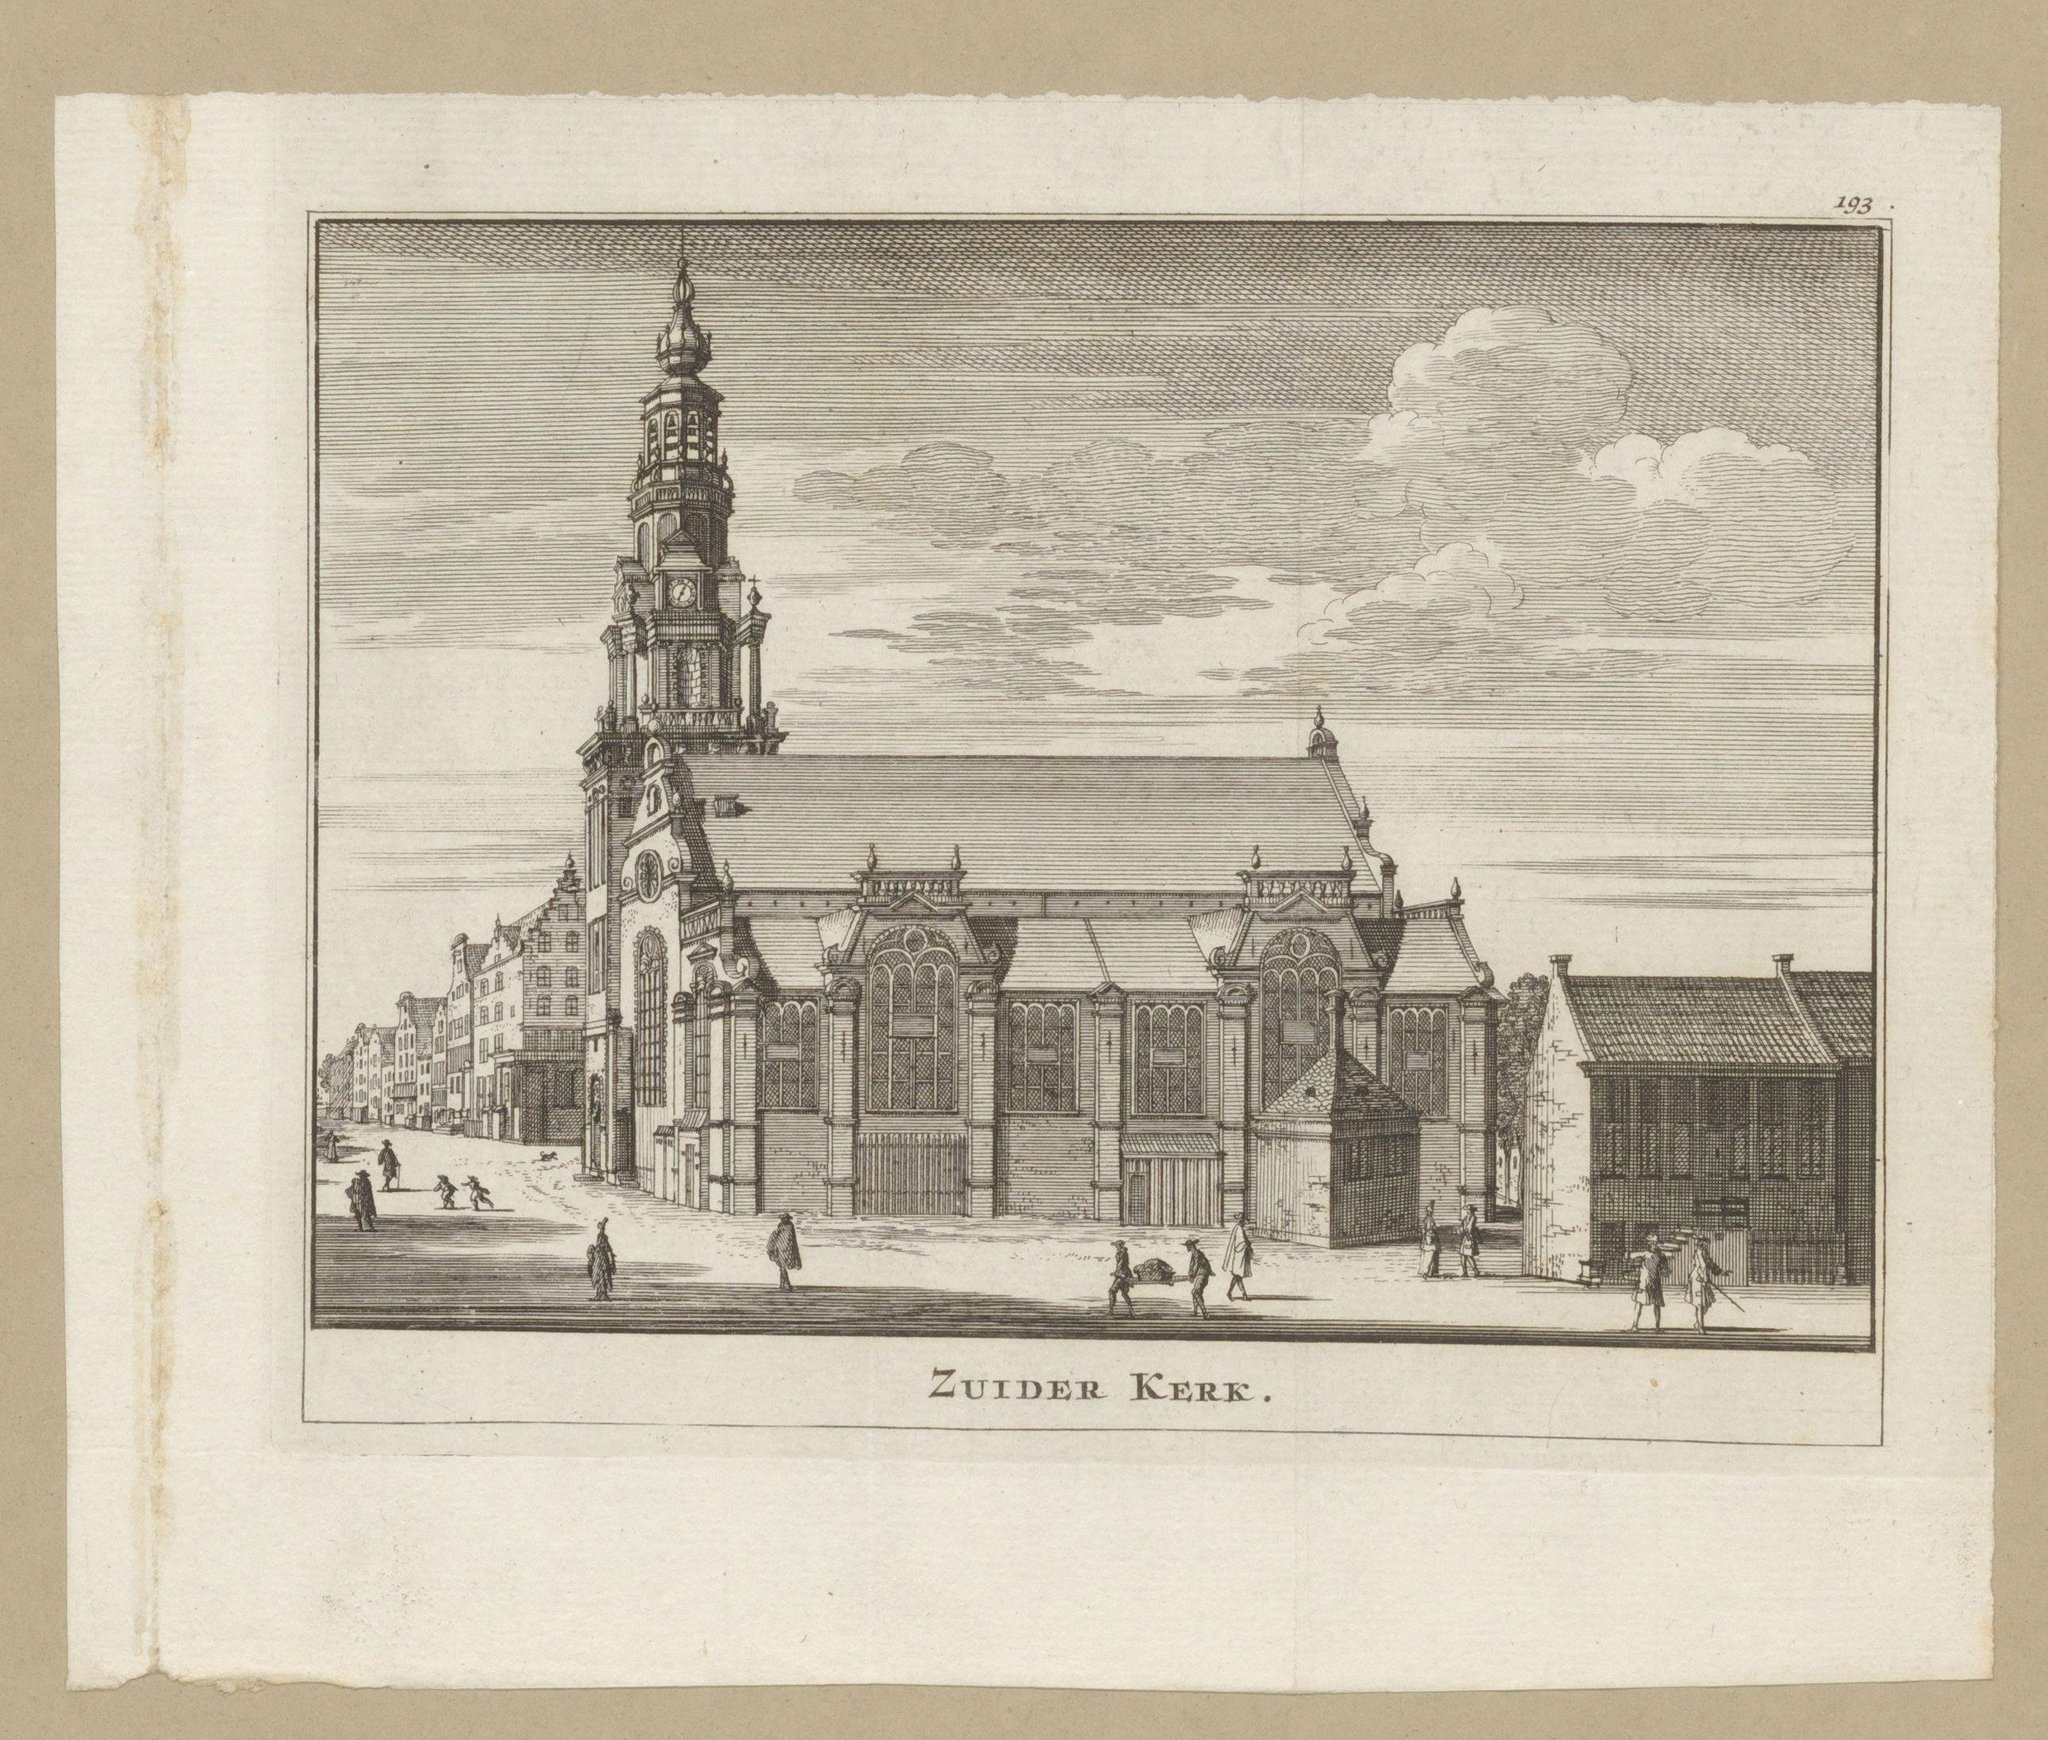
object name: print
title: Zuider Kerk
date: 1726-1751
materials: paper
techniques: engraving, etching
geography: amsterdam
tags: church (exterior), street (+ city(-scape) with figures, staffage)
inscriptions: collector's mark: Lugt 1641b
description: Prent mogelijk uit: Hoorn, Nicolaas ten. Wegwyzer door Amsterdam zynde eene beknopte verhandeling van desselfs eerste opkomst, vergrootingen, en teegenwoordigen staat (...). Amsterdam: Nicolaas ten Hoorn, 1726. Of uit: Hoorn, Nicolaas ten. Wegwyzer, of korte beschryvinge van de stadt Amsterdam, zynde eene beknopte verhandeling van desselfs eerste opkomst, vergrootingen, en teegenwoordigen staat (...). Amsterdam: erven J. Ratelband & Co, 1737. Of uit: Hoorn, Nicolaas ten. Wegwyzer of korte beschryvinge der stad Amsterdam, zynde eene beknopte verhandeling van derzelver eerste opkomst, vergrootingen, en tegenwoordigen staat (...). Amsterdam: Pieter Meyer, 1751.